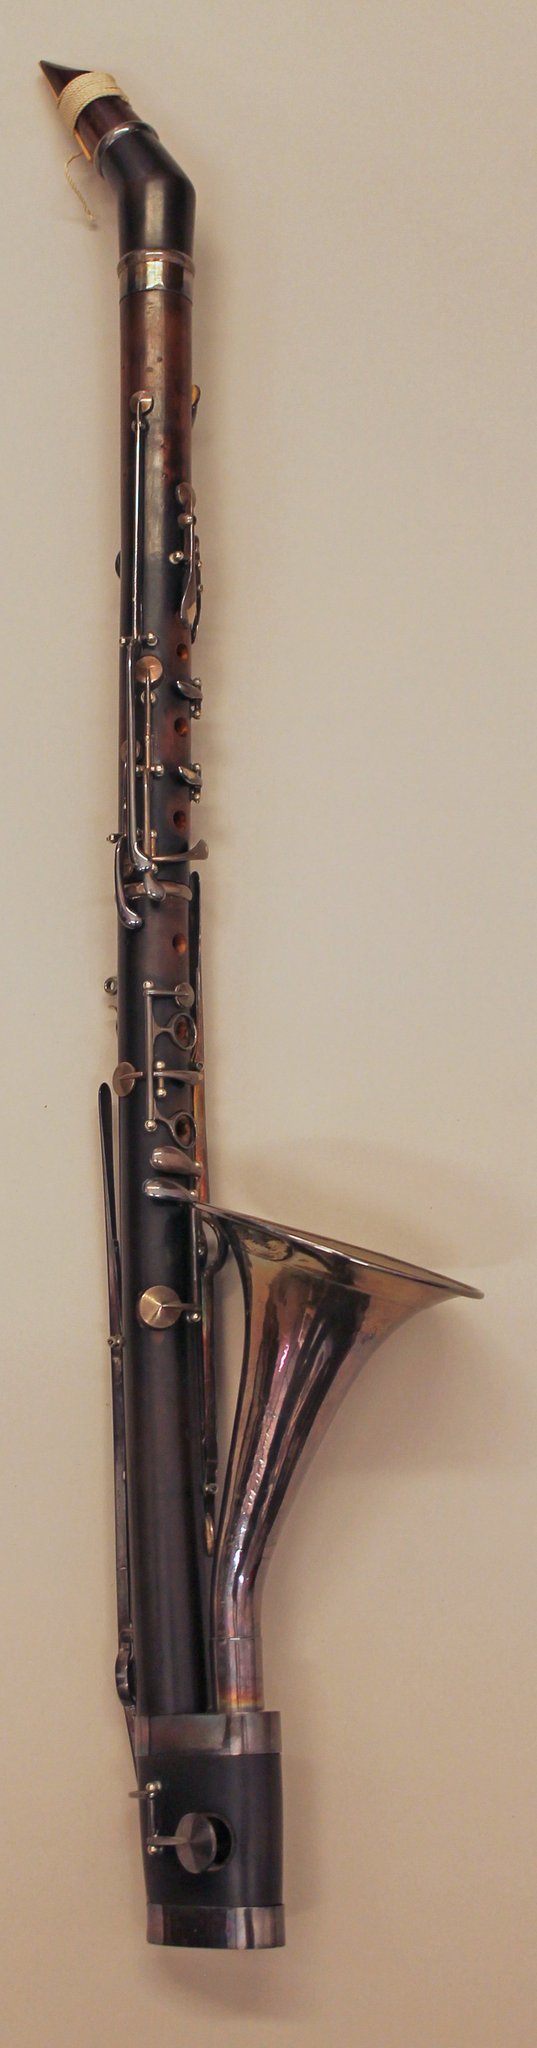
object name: basset horn in f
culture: german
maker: joseph seidel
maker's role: maker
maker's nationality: german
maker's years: 1800-1870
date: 1860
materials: wood, nickel, silver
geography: germany